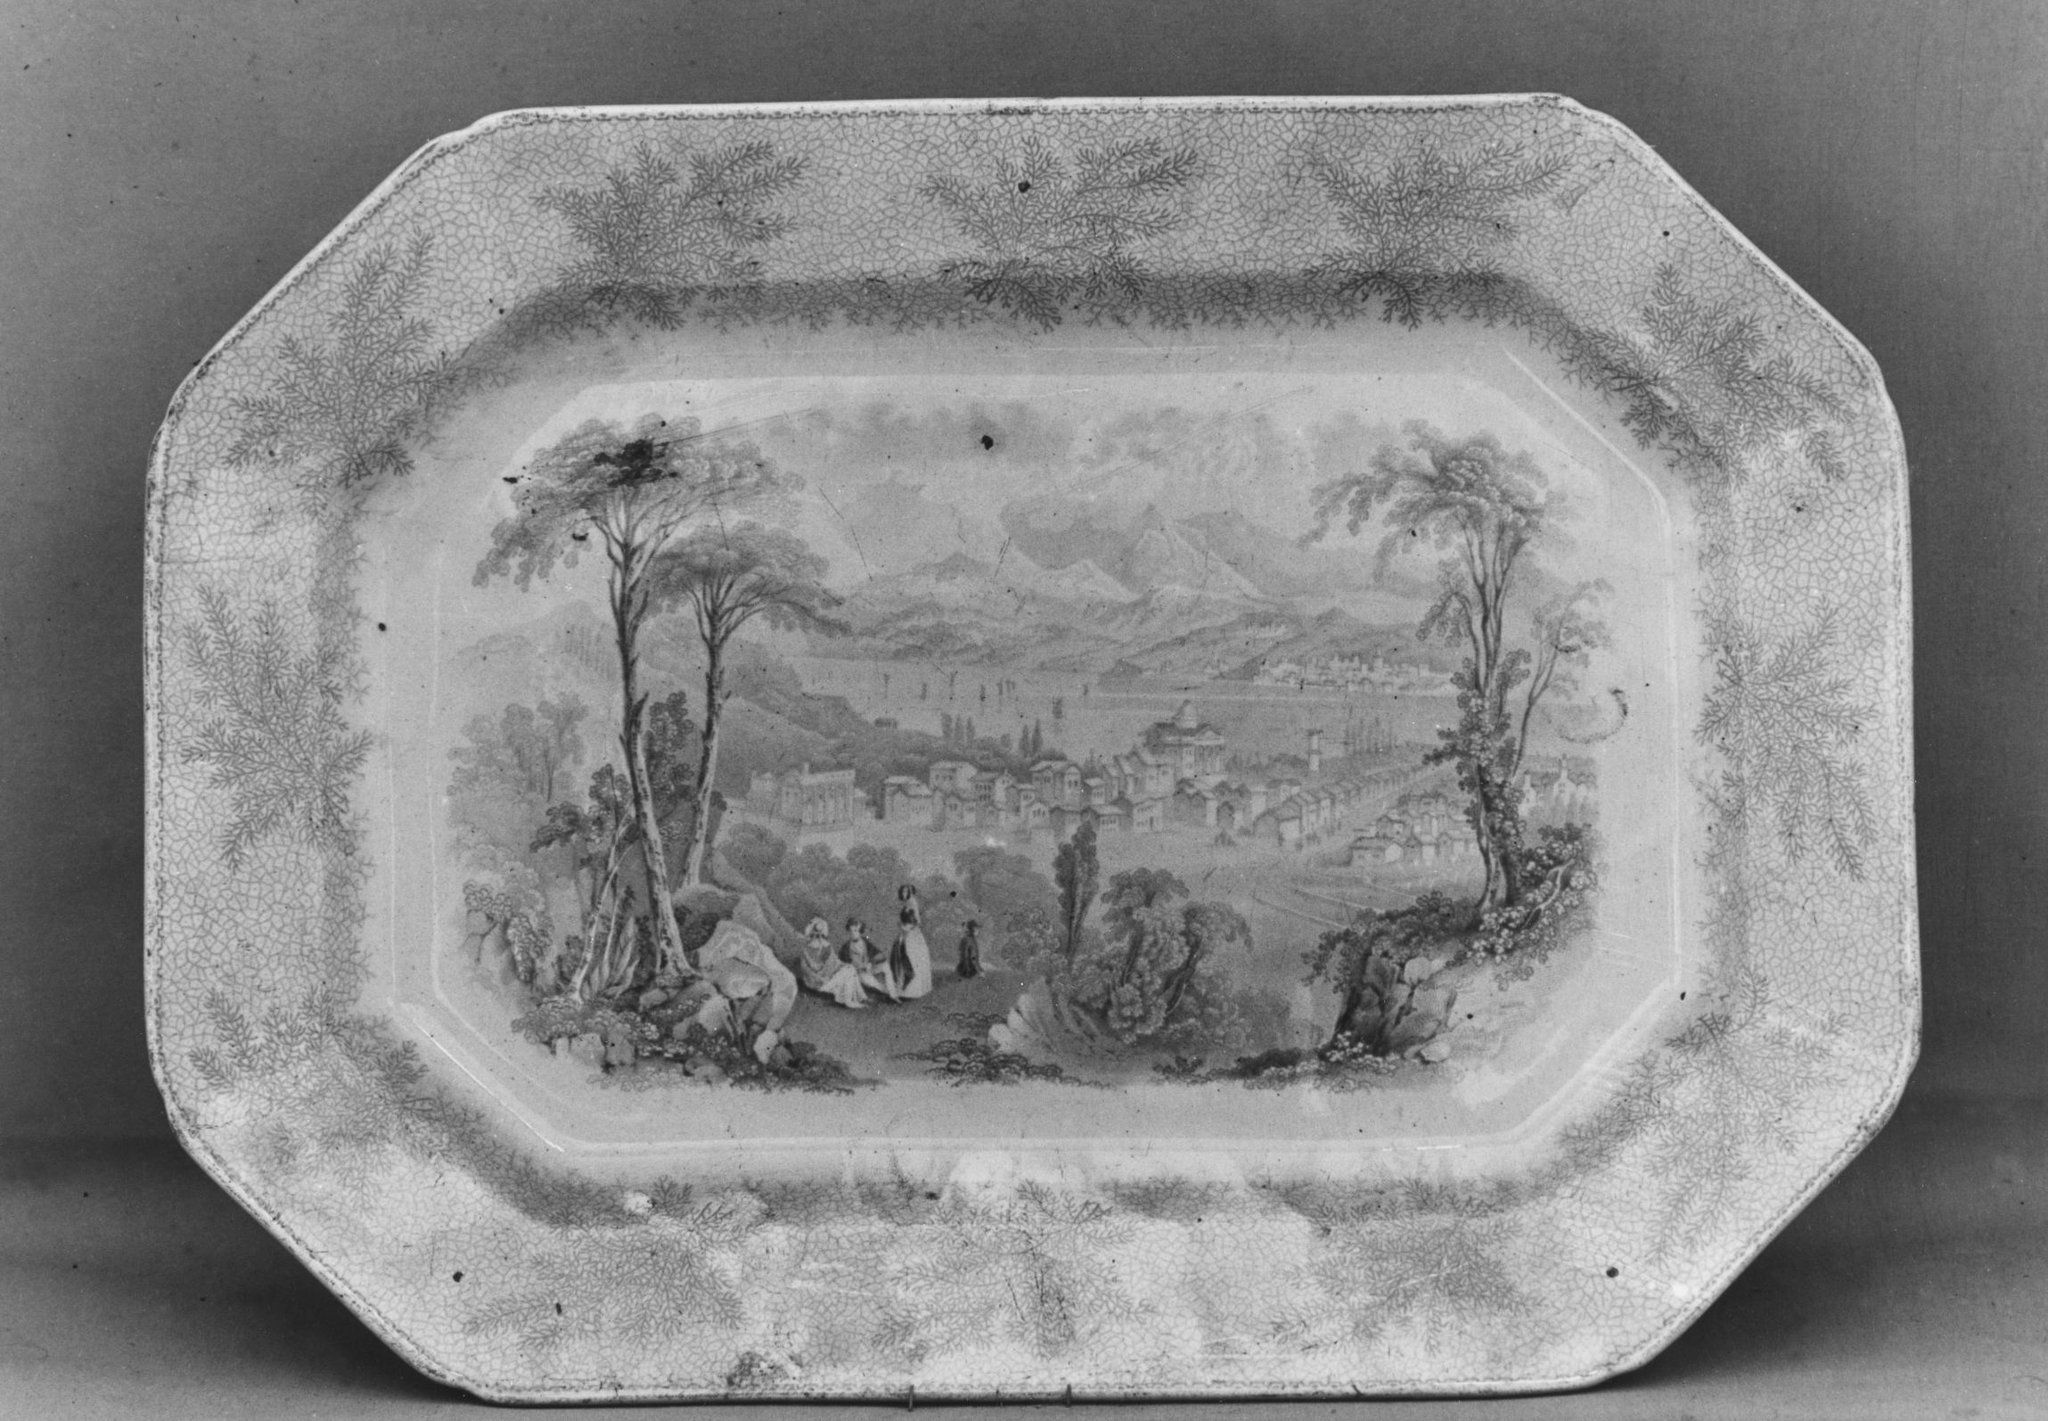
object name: platter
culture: british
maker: william ridgway, son & co.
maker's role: maker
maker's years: 1833-1848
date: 1844-1846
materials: earthenware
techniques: transfer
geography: england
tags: landscapes